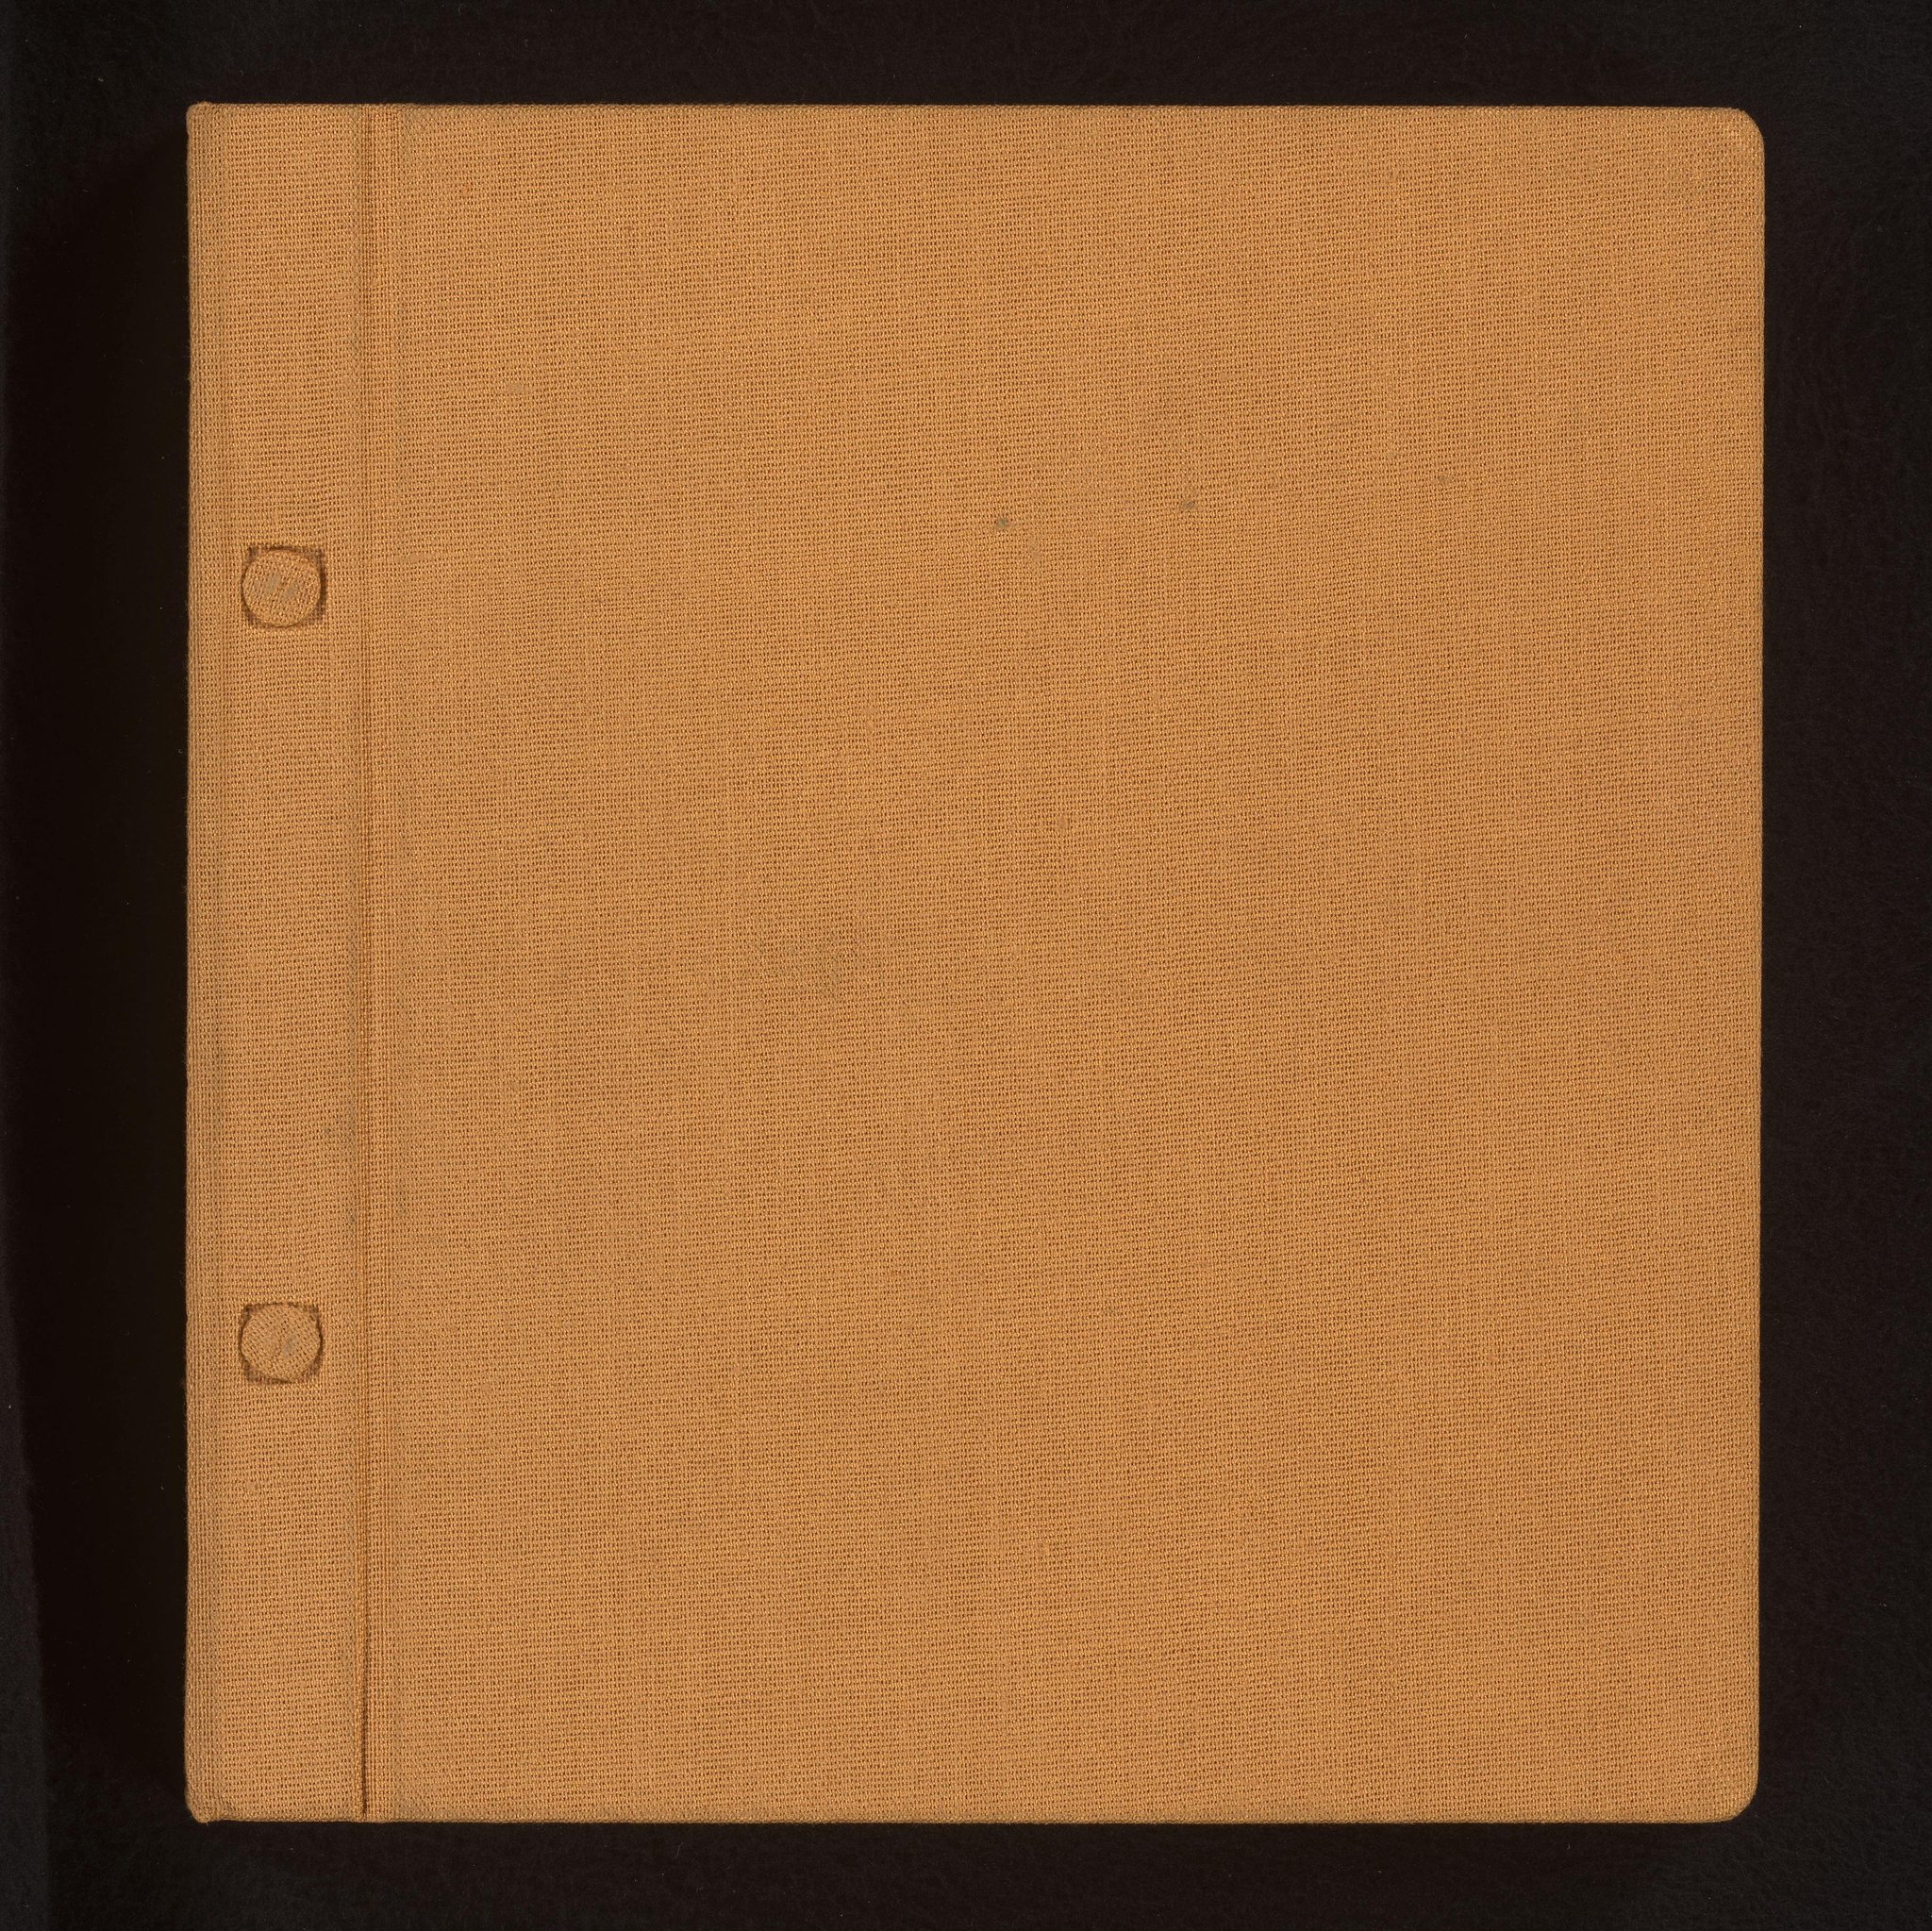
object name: photograph album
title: Album Deutsche Reichsbahn, 1943-1944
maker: Anonymous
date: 1943-1944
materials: cardboard, paper, photographic support, textile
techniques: gelatin silver print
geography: netherlands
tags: utrecht, arnhem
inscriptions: inscription: ‘Zum 8. Dezember 1950 / Hedwig Schûbert’, inscription: ‘FOTOS’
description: Duits militair fotoalbum uit de Tweede Wereldoorlog met een geel stoffen omslag. Hierin 22 groene kartonnen binnenbladen met tussenbladen, met twee pinnen in omslag gebonden. Op de bladen 50 zwart-wit foto's van onder andere een Kerstviering in Utrecht in 1943, met een vlag met hakenkruis op de achtergrond, toneelstuk, uitstapjes van enkele officieren met hun vrouwen of vriendinnen in Kronenburger park, Velp en Arnhem, ansichtkaart van de Nieuwe Schouwburg in Utrecht, Duitsers poserend in Volendammer klederdracht, lichamelijke oefening. 13 Bladen blanco en 9 losse foto's in envelop, waarvan enkele duplicaten uit het fotoalbum.